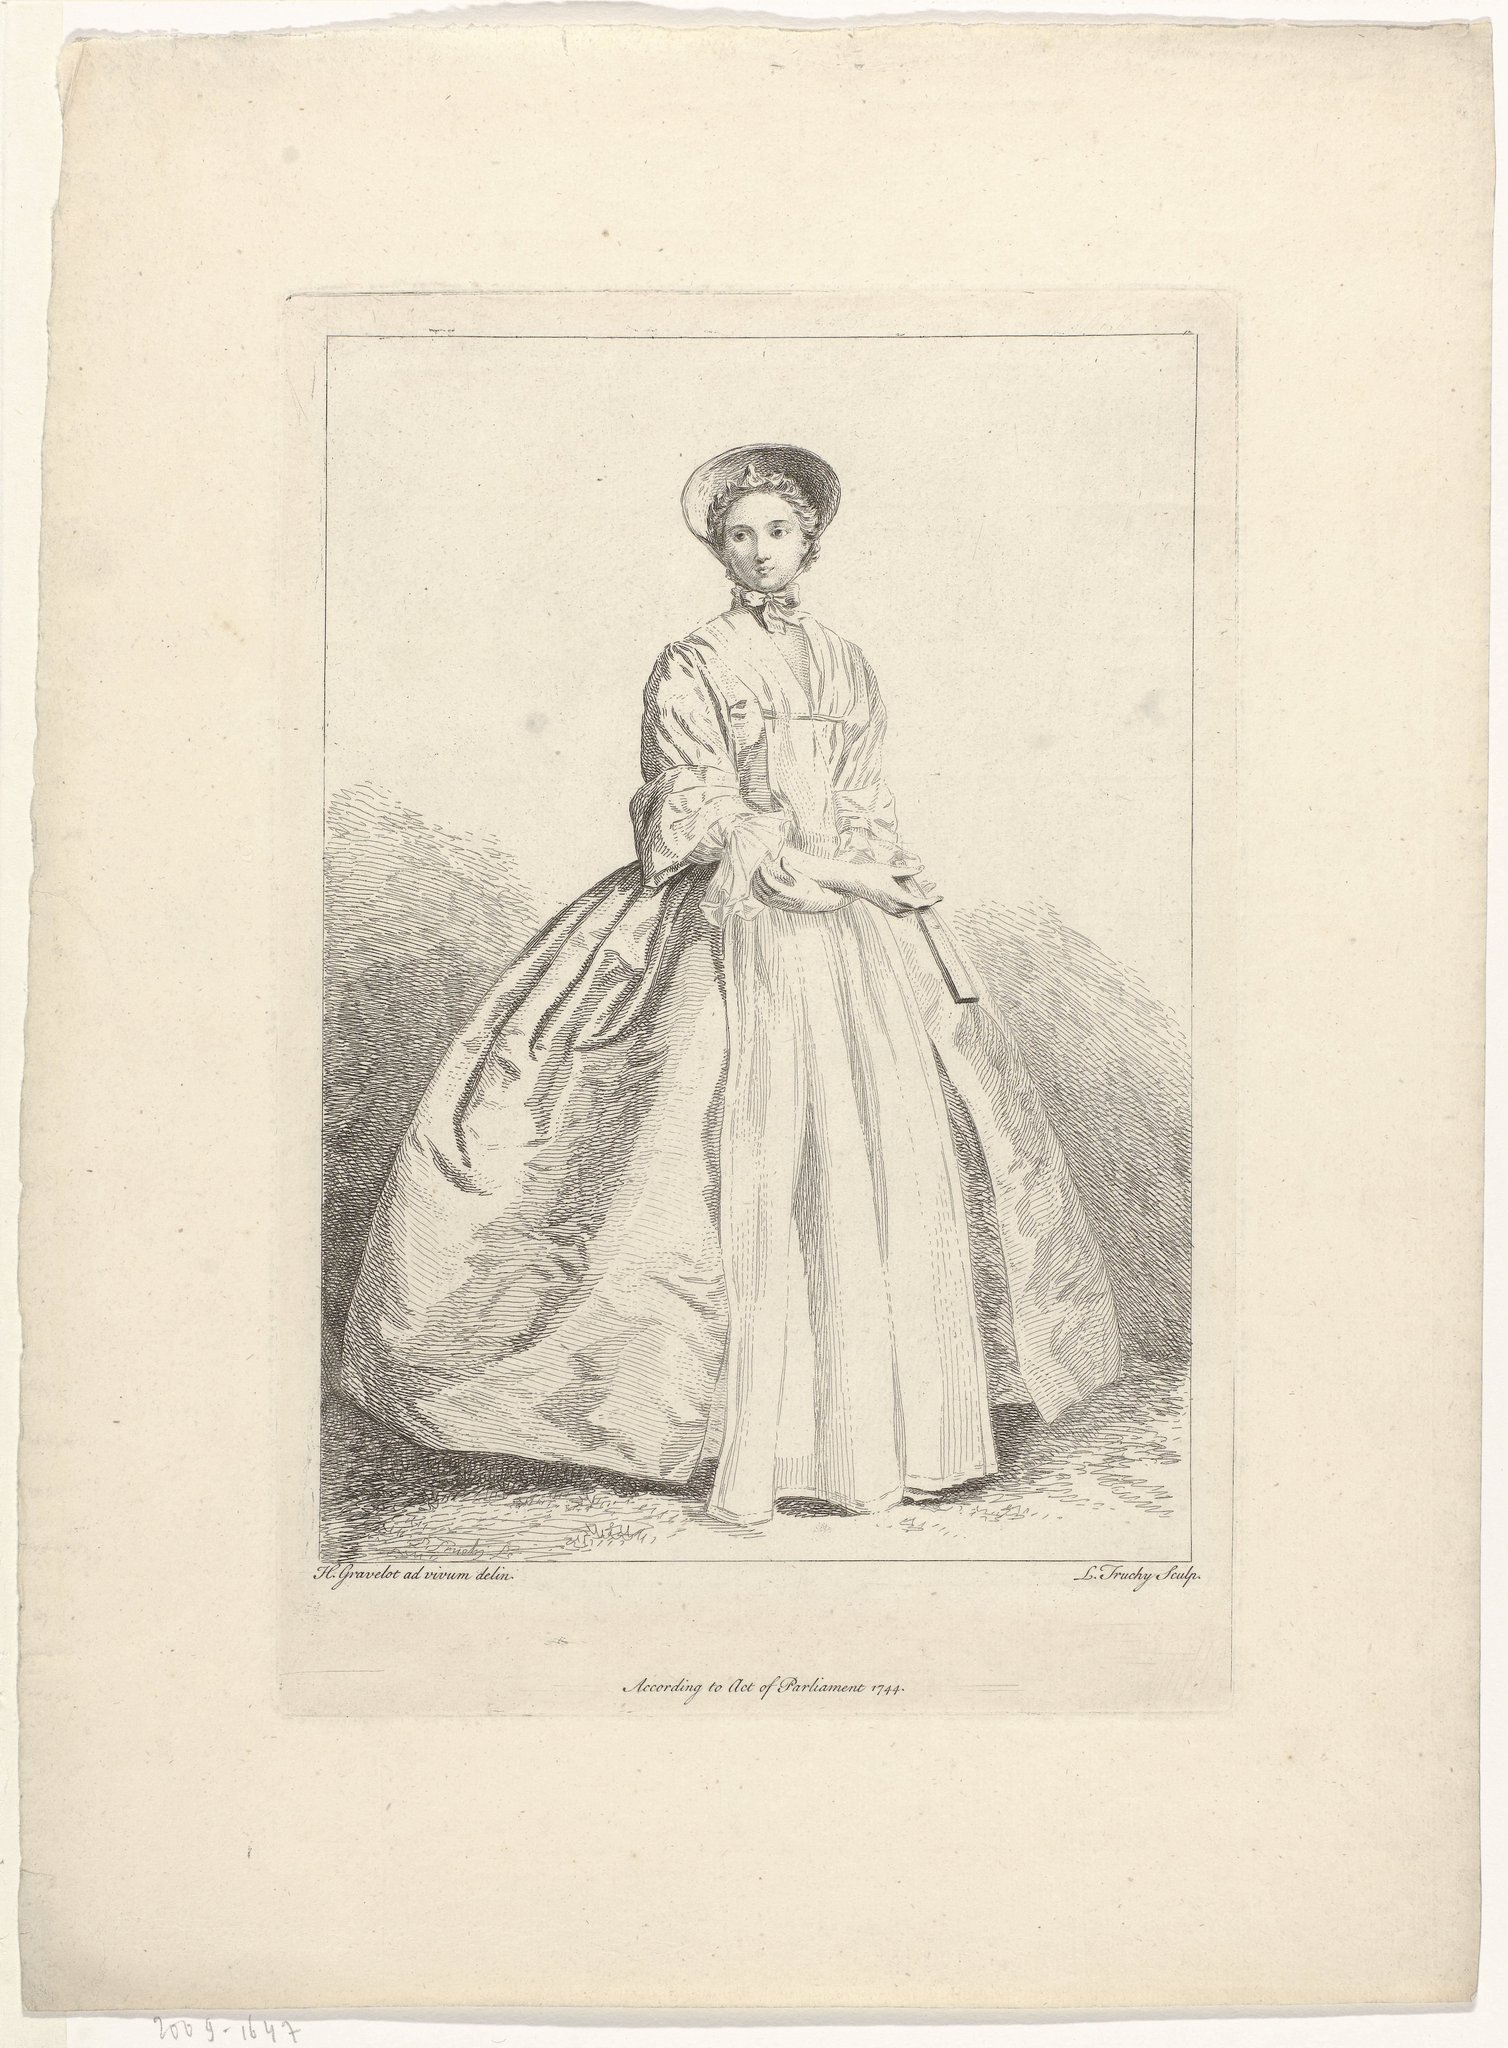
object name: costume print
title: Fashion and Elegance: Fashionable Ladies and Gentlemen of the 1740s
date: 1744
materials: paper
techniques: etching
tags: fashion plates, dress, gown (+ women's clothes), fan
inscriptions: date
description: During the early 18th century small series of costume plates reported on the fashion of the day. Women wore the loose-fitting robe volante, also called a ‘sack-backed gown’ in English, over which women sometimes added a short, hooded cloak known as a bagnolette. Men dressed in long coats over a waistcoat and knee-breeches. Pig-tail wigs were adorned with large bows, and tricorne hats were tucked under the arm rather than worn on the head. The two large prints from around 1760 show Parisians out for a stroll. Curiously, the women wear wide paniers (hoop skirts) for their promenade on the ramparts. In the caption underneath, they are condemned as silly slaves of fashion who blindly follow the dictates of the latest trends.